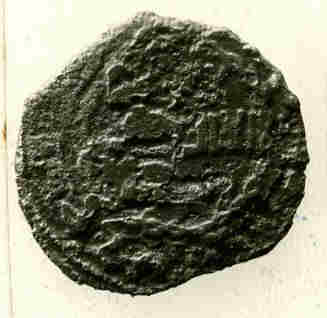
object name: coin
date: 758-768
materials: copper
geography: iran